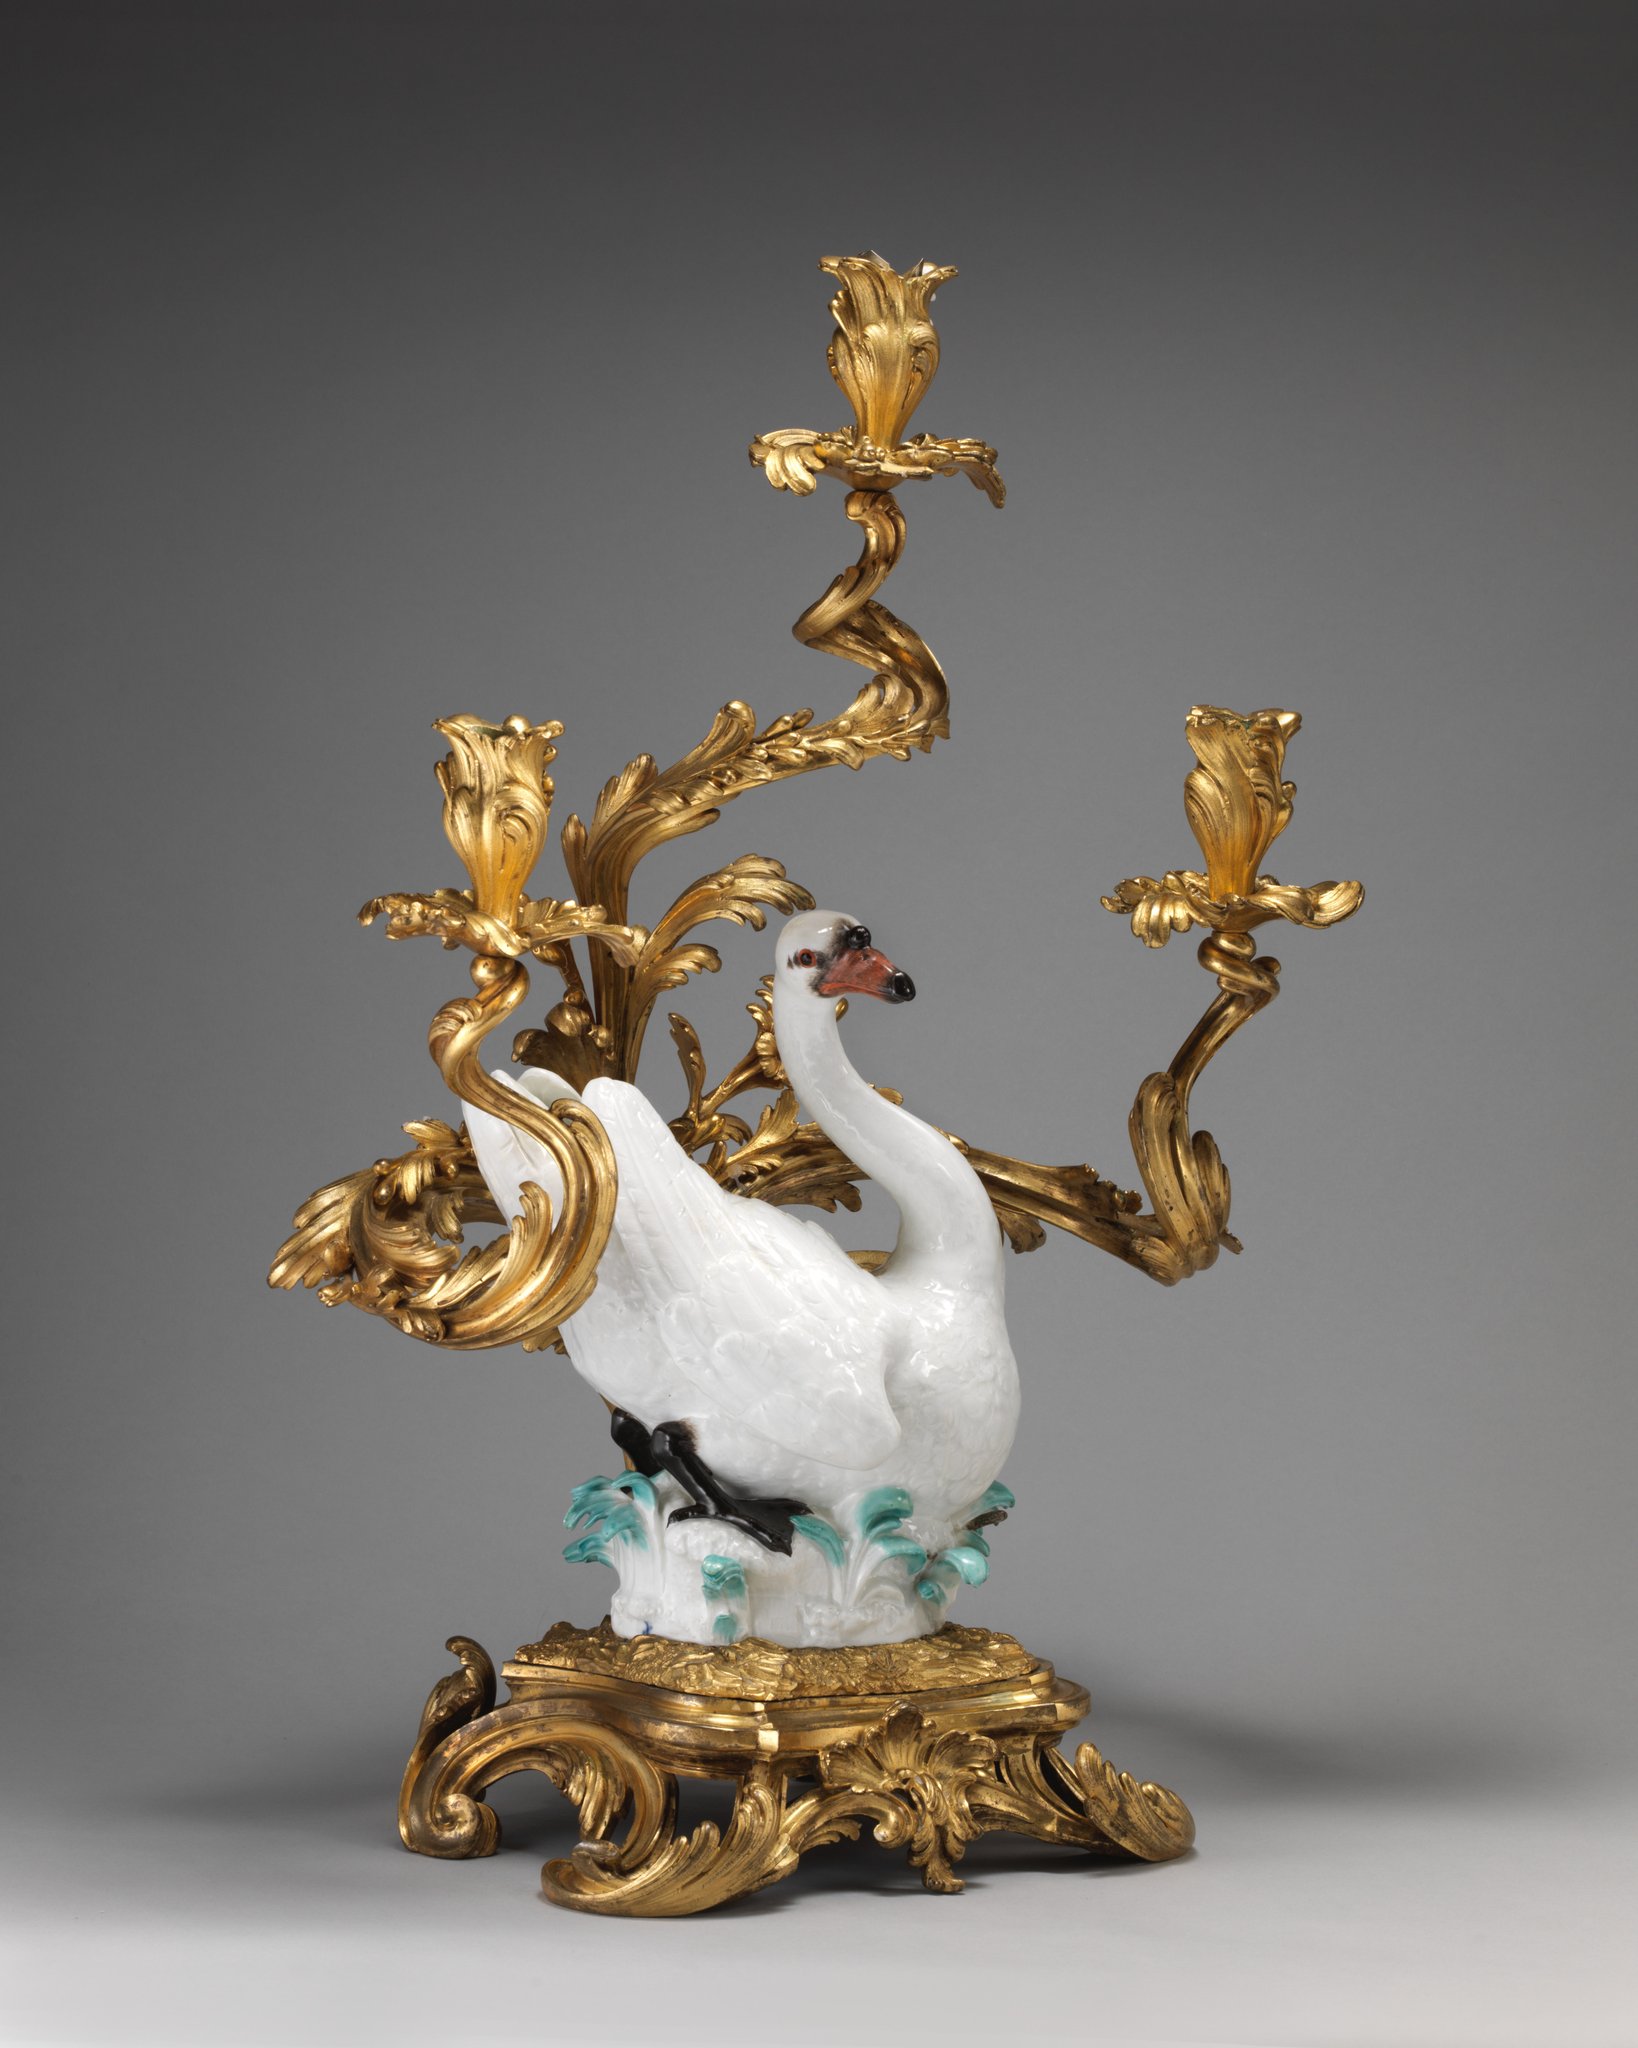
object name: candelabrum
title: Swan candelabrum (one of a pair)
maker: meissen manufactory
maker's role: manufactory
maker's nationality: german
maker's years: 1710-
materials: gilt bronze, hard paste porcelain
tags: swans